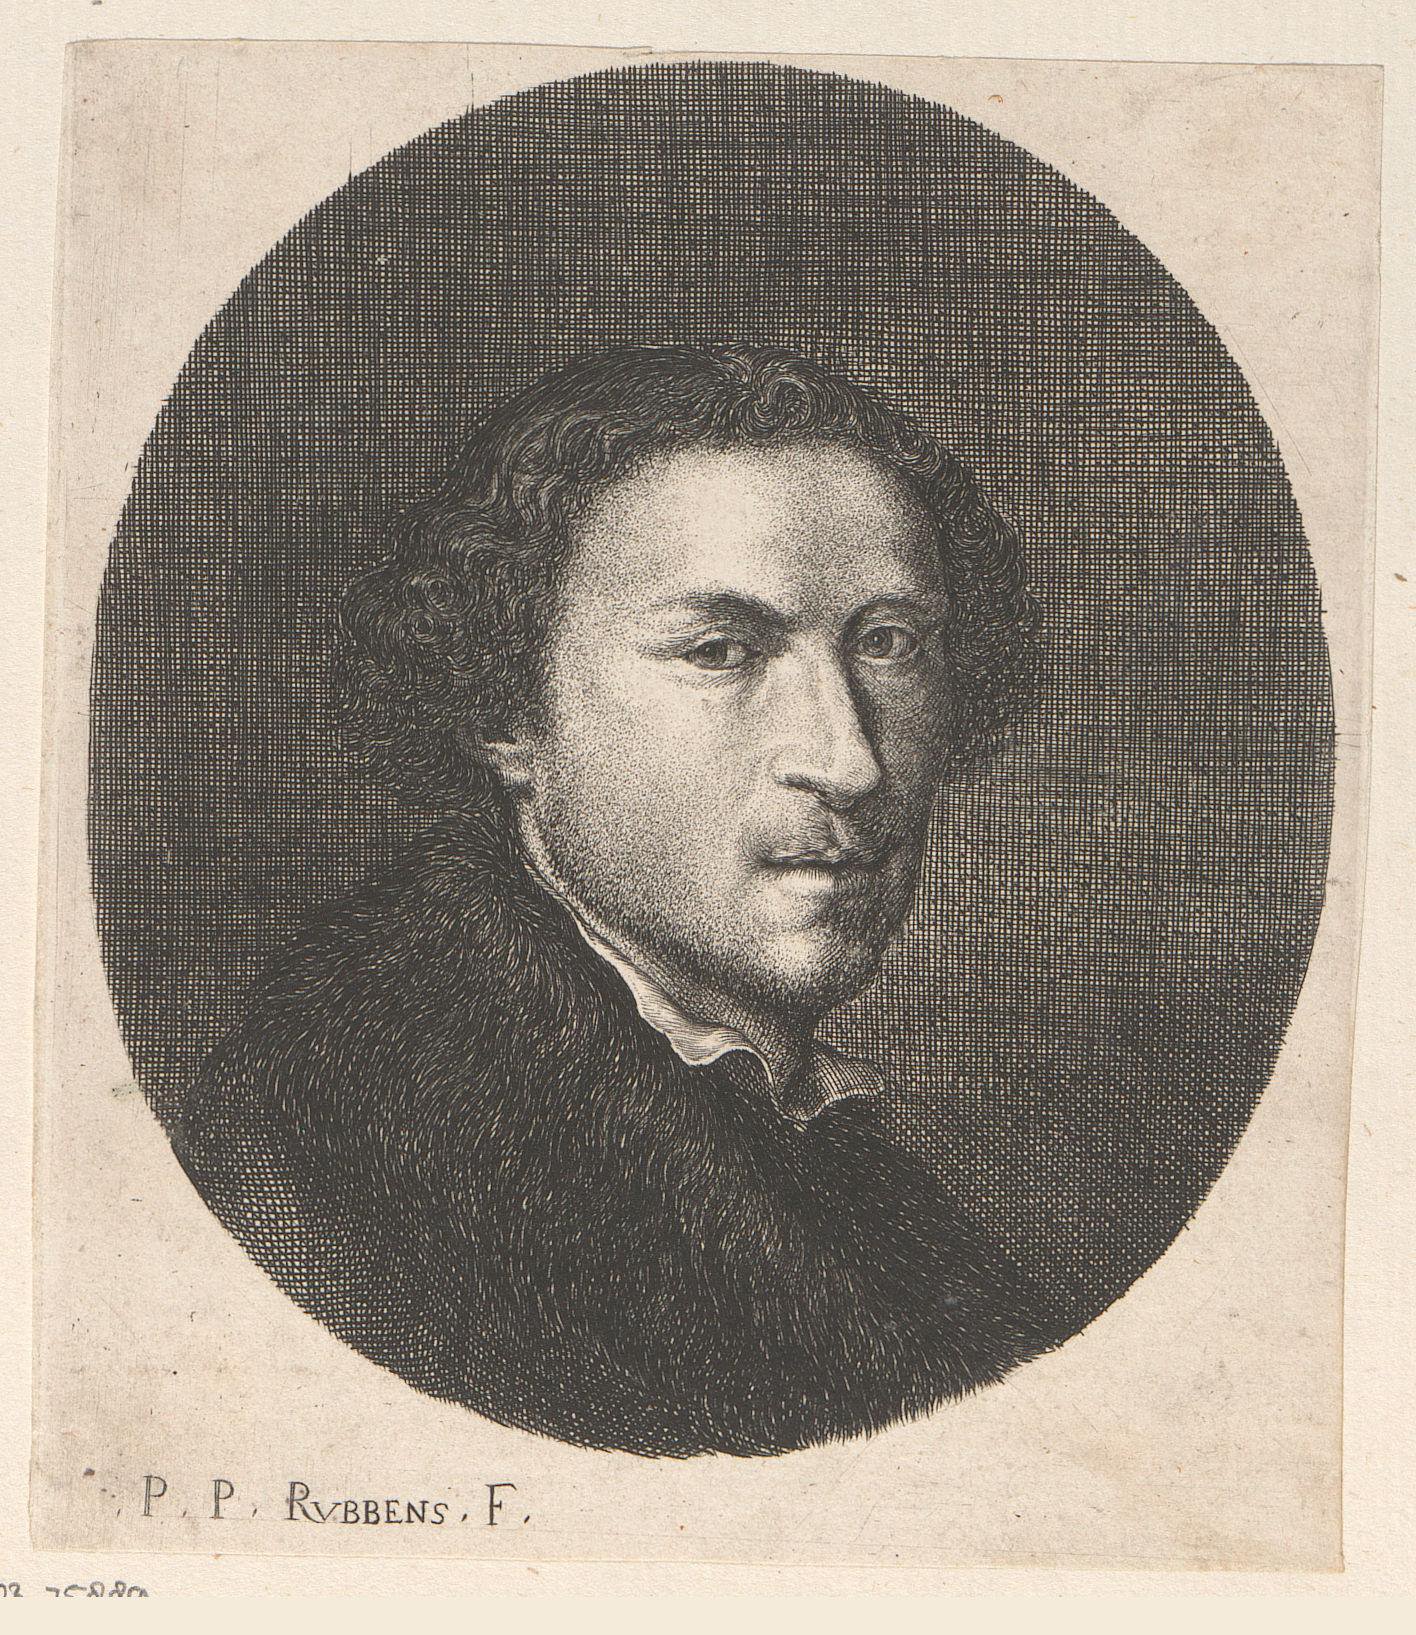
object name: album leaf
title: Portret van een onbekende man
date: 1620-1750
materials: paper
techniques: engraving, etching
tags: historical persons not known by name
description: Portret van een onbekende man, buste driekwart naar rechts, in zwarte ovaal. Deze prent maakt deel uit van een album.